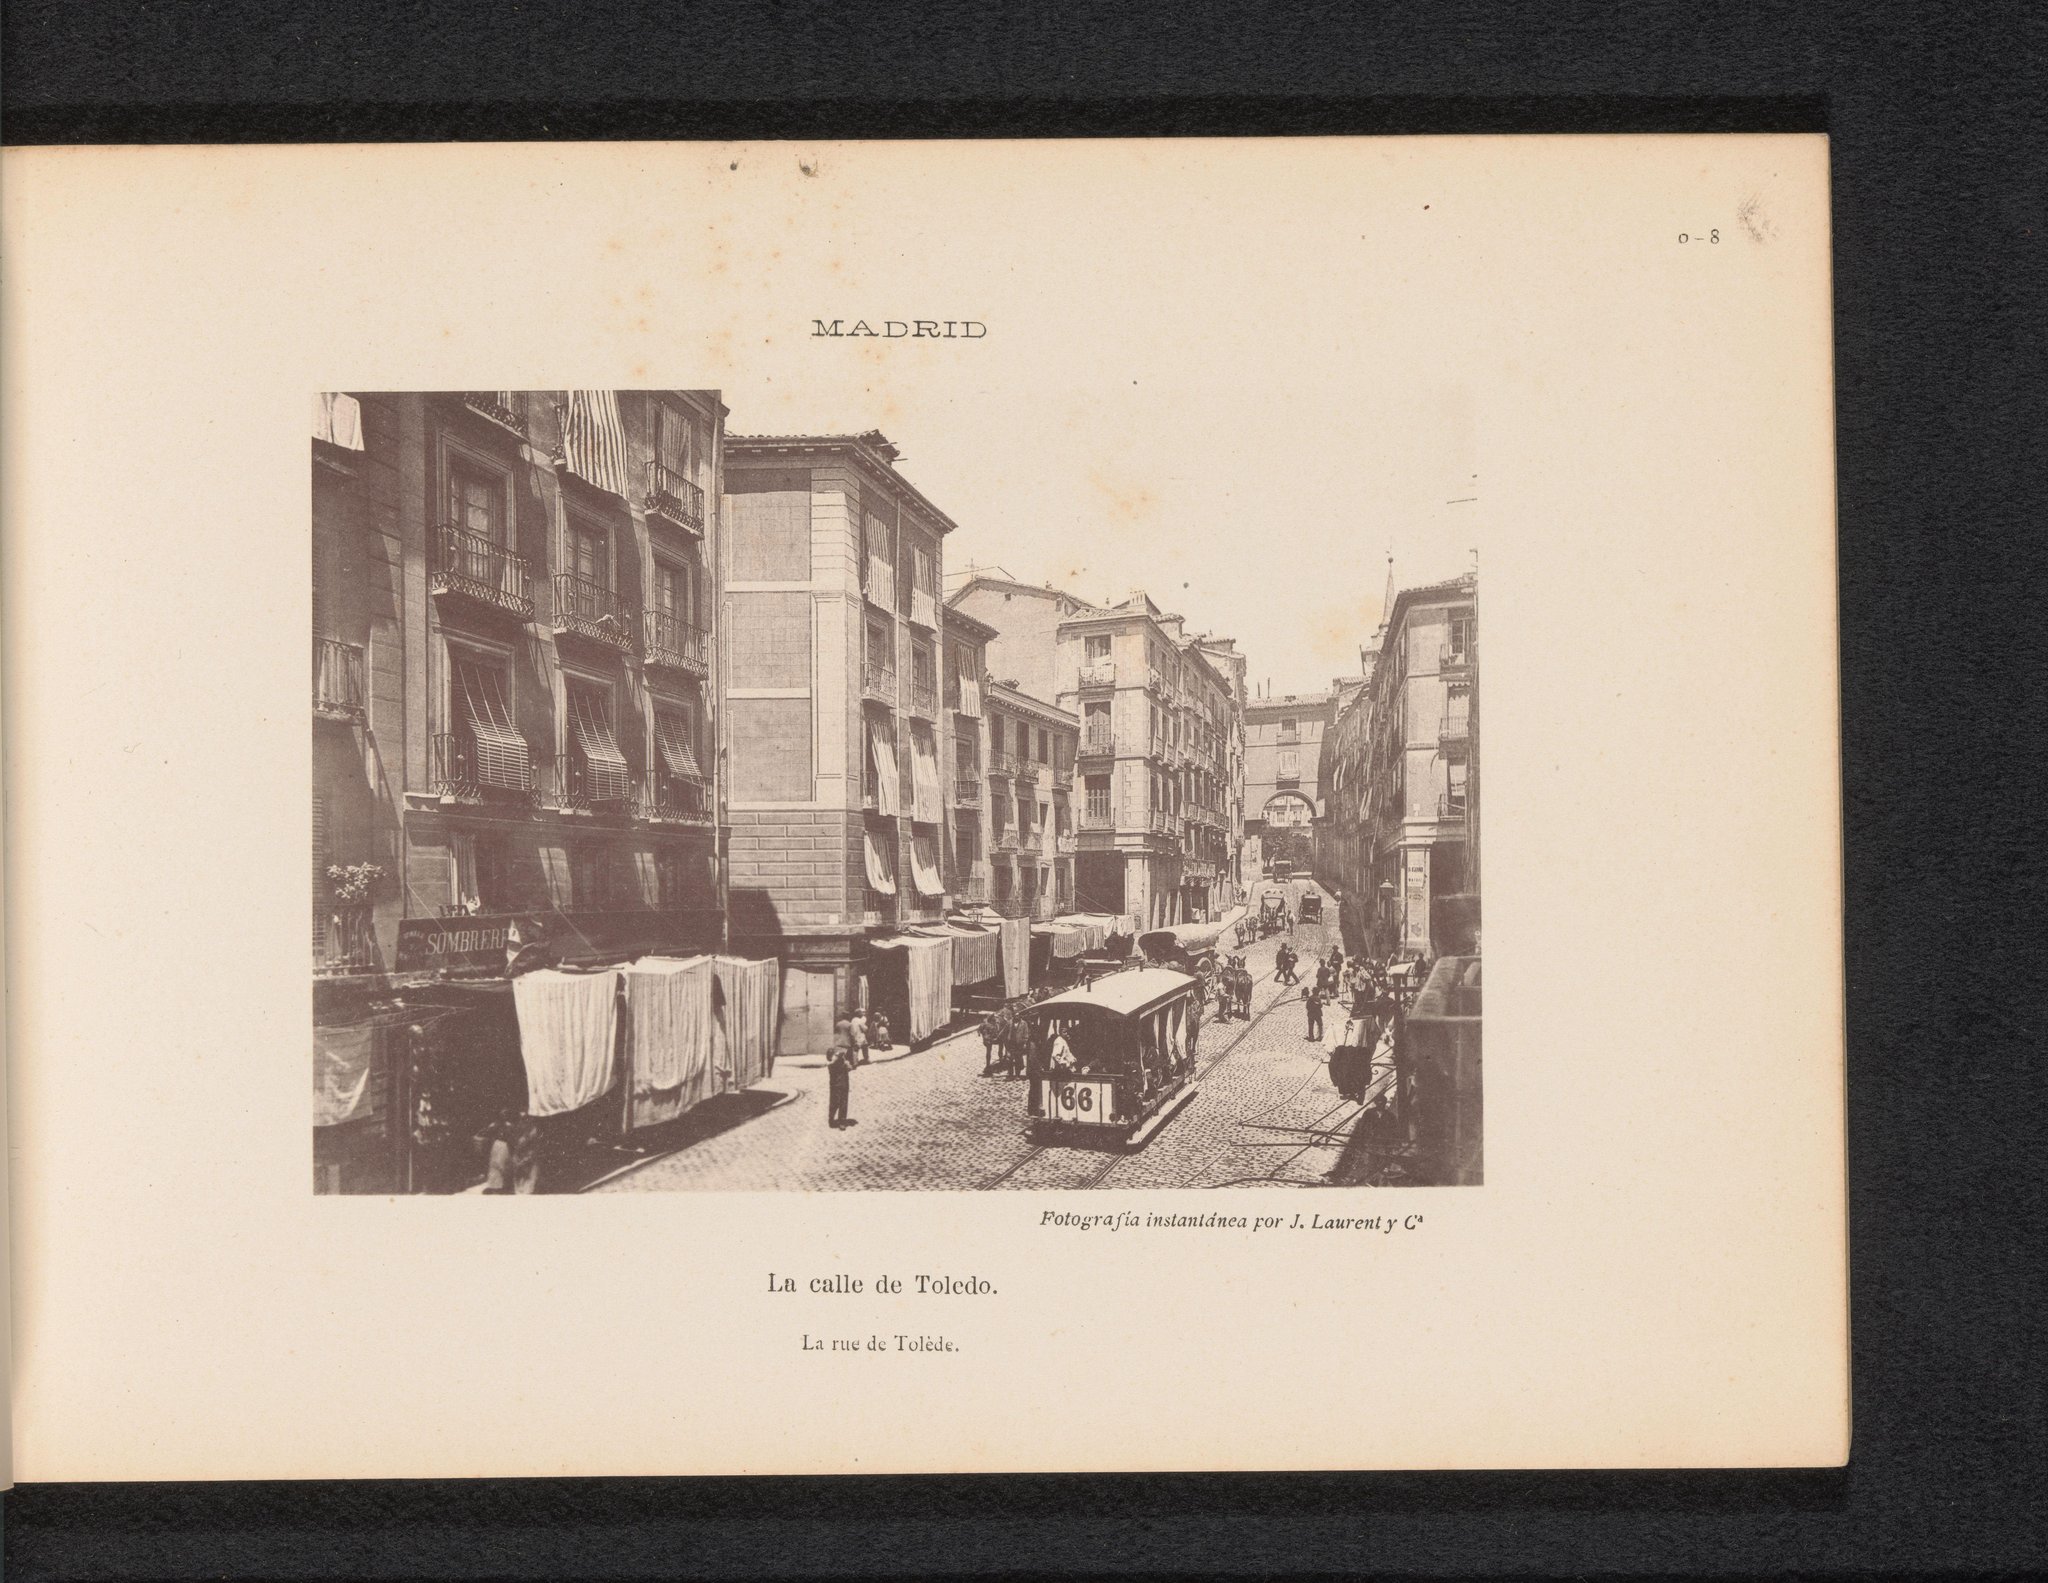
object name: photomechanical print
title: La calle de Toledo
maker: juan laurent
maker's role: publisher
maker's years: 1816-1896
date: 1880-1890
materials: paper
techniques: photograph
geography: madrid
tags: tramway, tram, street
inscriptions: number: ‘0-8’